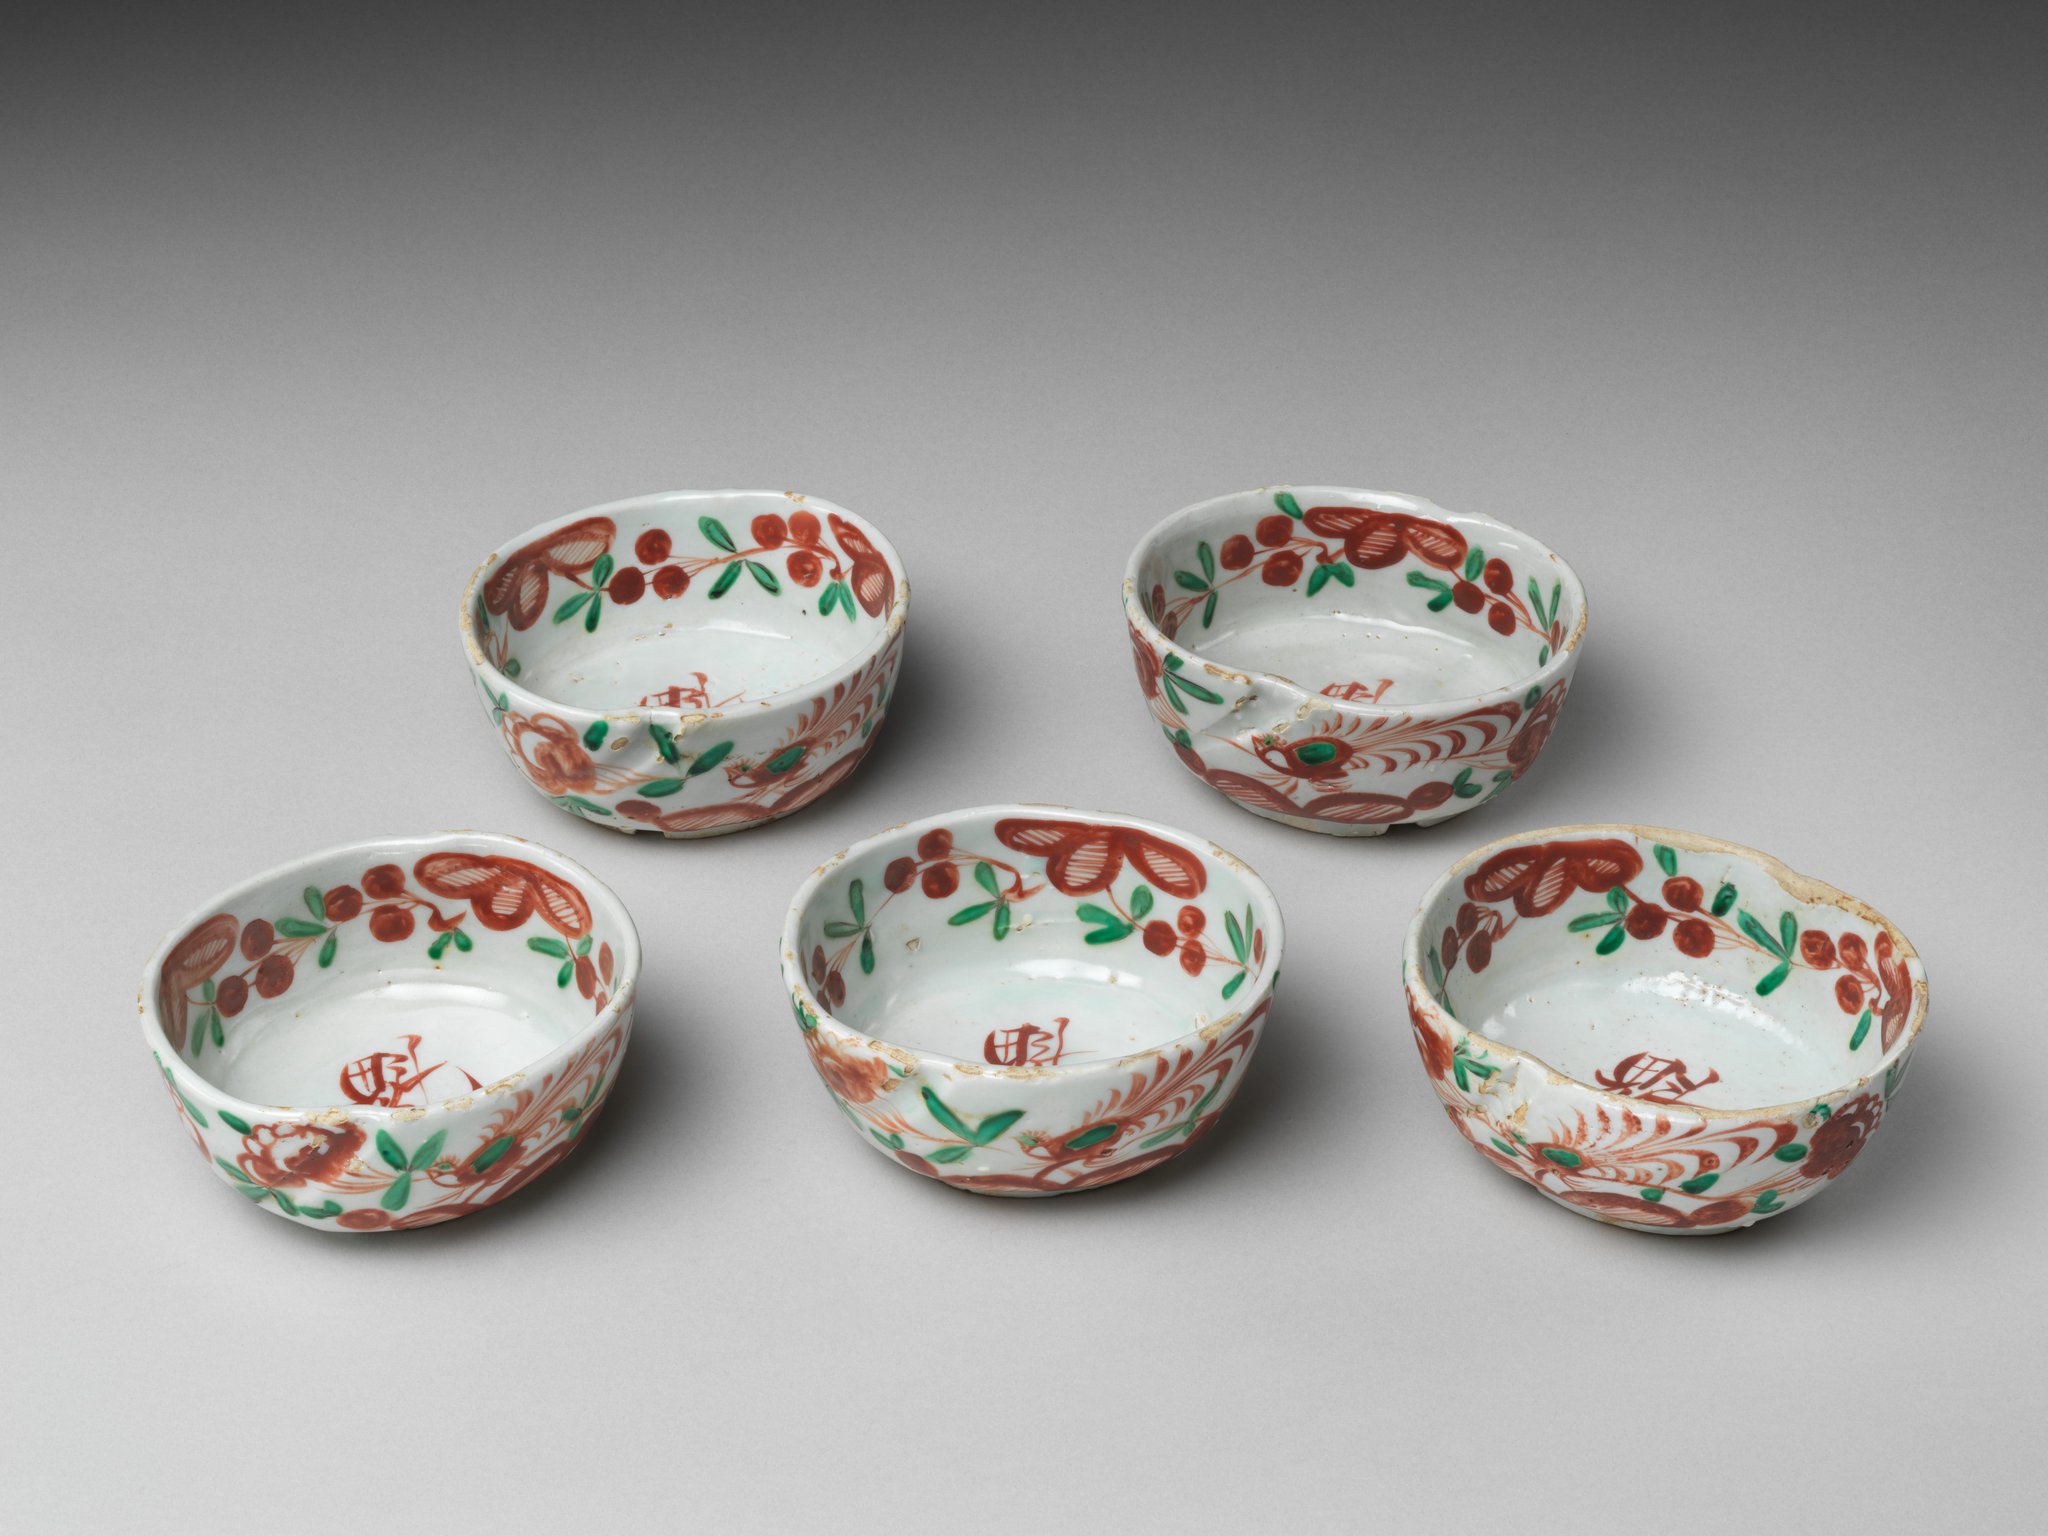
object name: bowl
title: Set of five bowls (Mukozuke)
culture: japanese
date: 1615-1868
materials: earthenware, glaze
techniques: polychrome